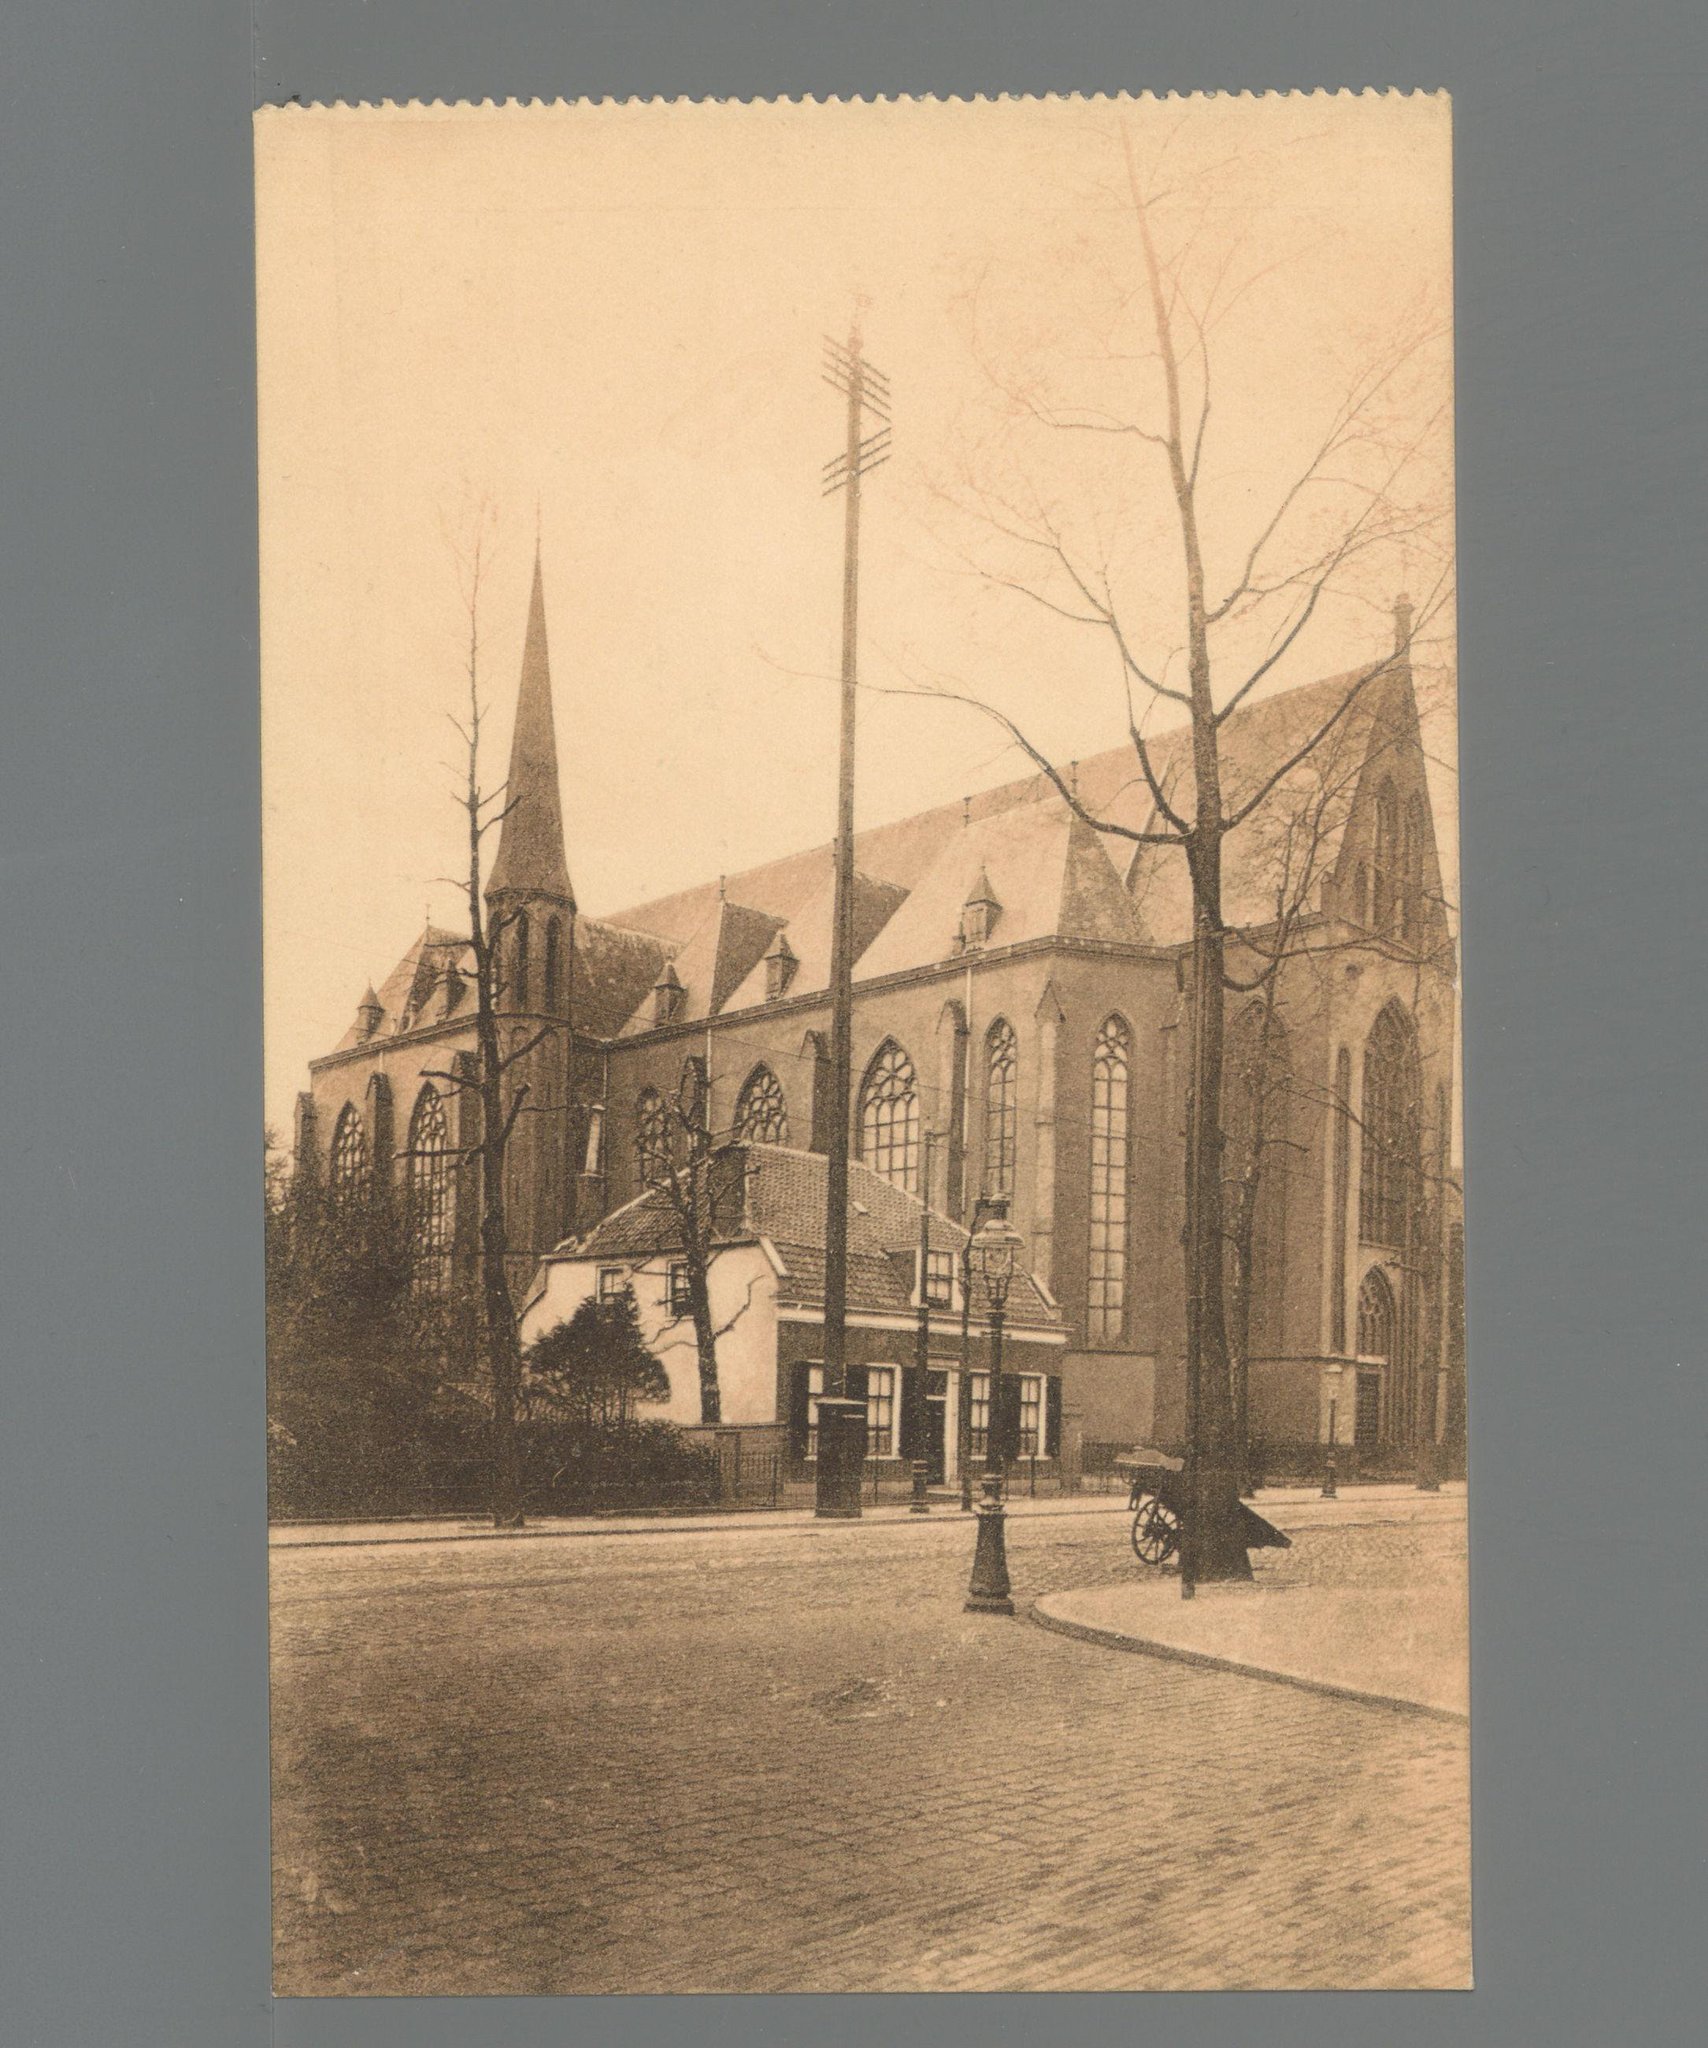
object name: ansichtkaart, prentbriefkaart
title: Parochiekerk O. L. Vr. Hemelvaart. Utrecht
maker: Anonymous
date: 1905-1930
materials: cardboard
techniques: photograph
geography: utrecht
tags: church (exterior)